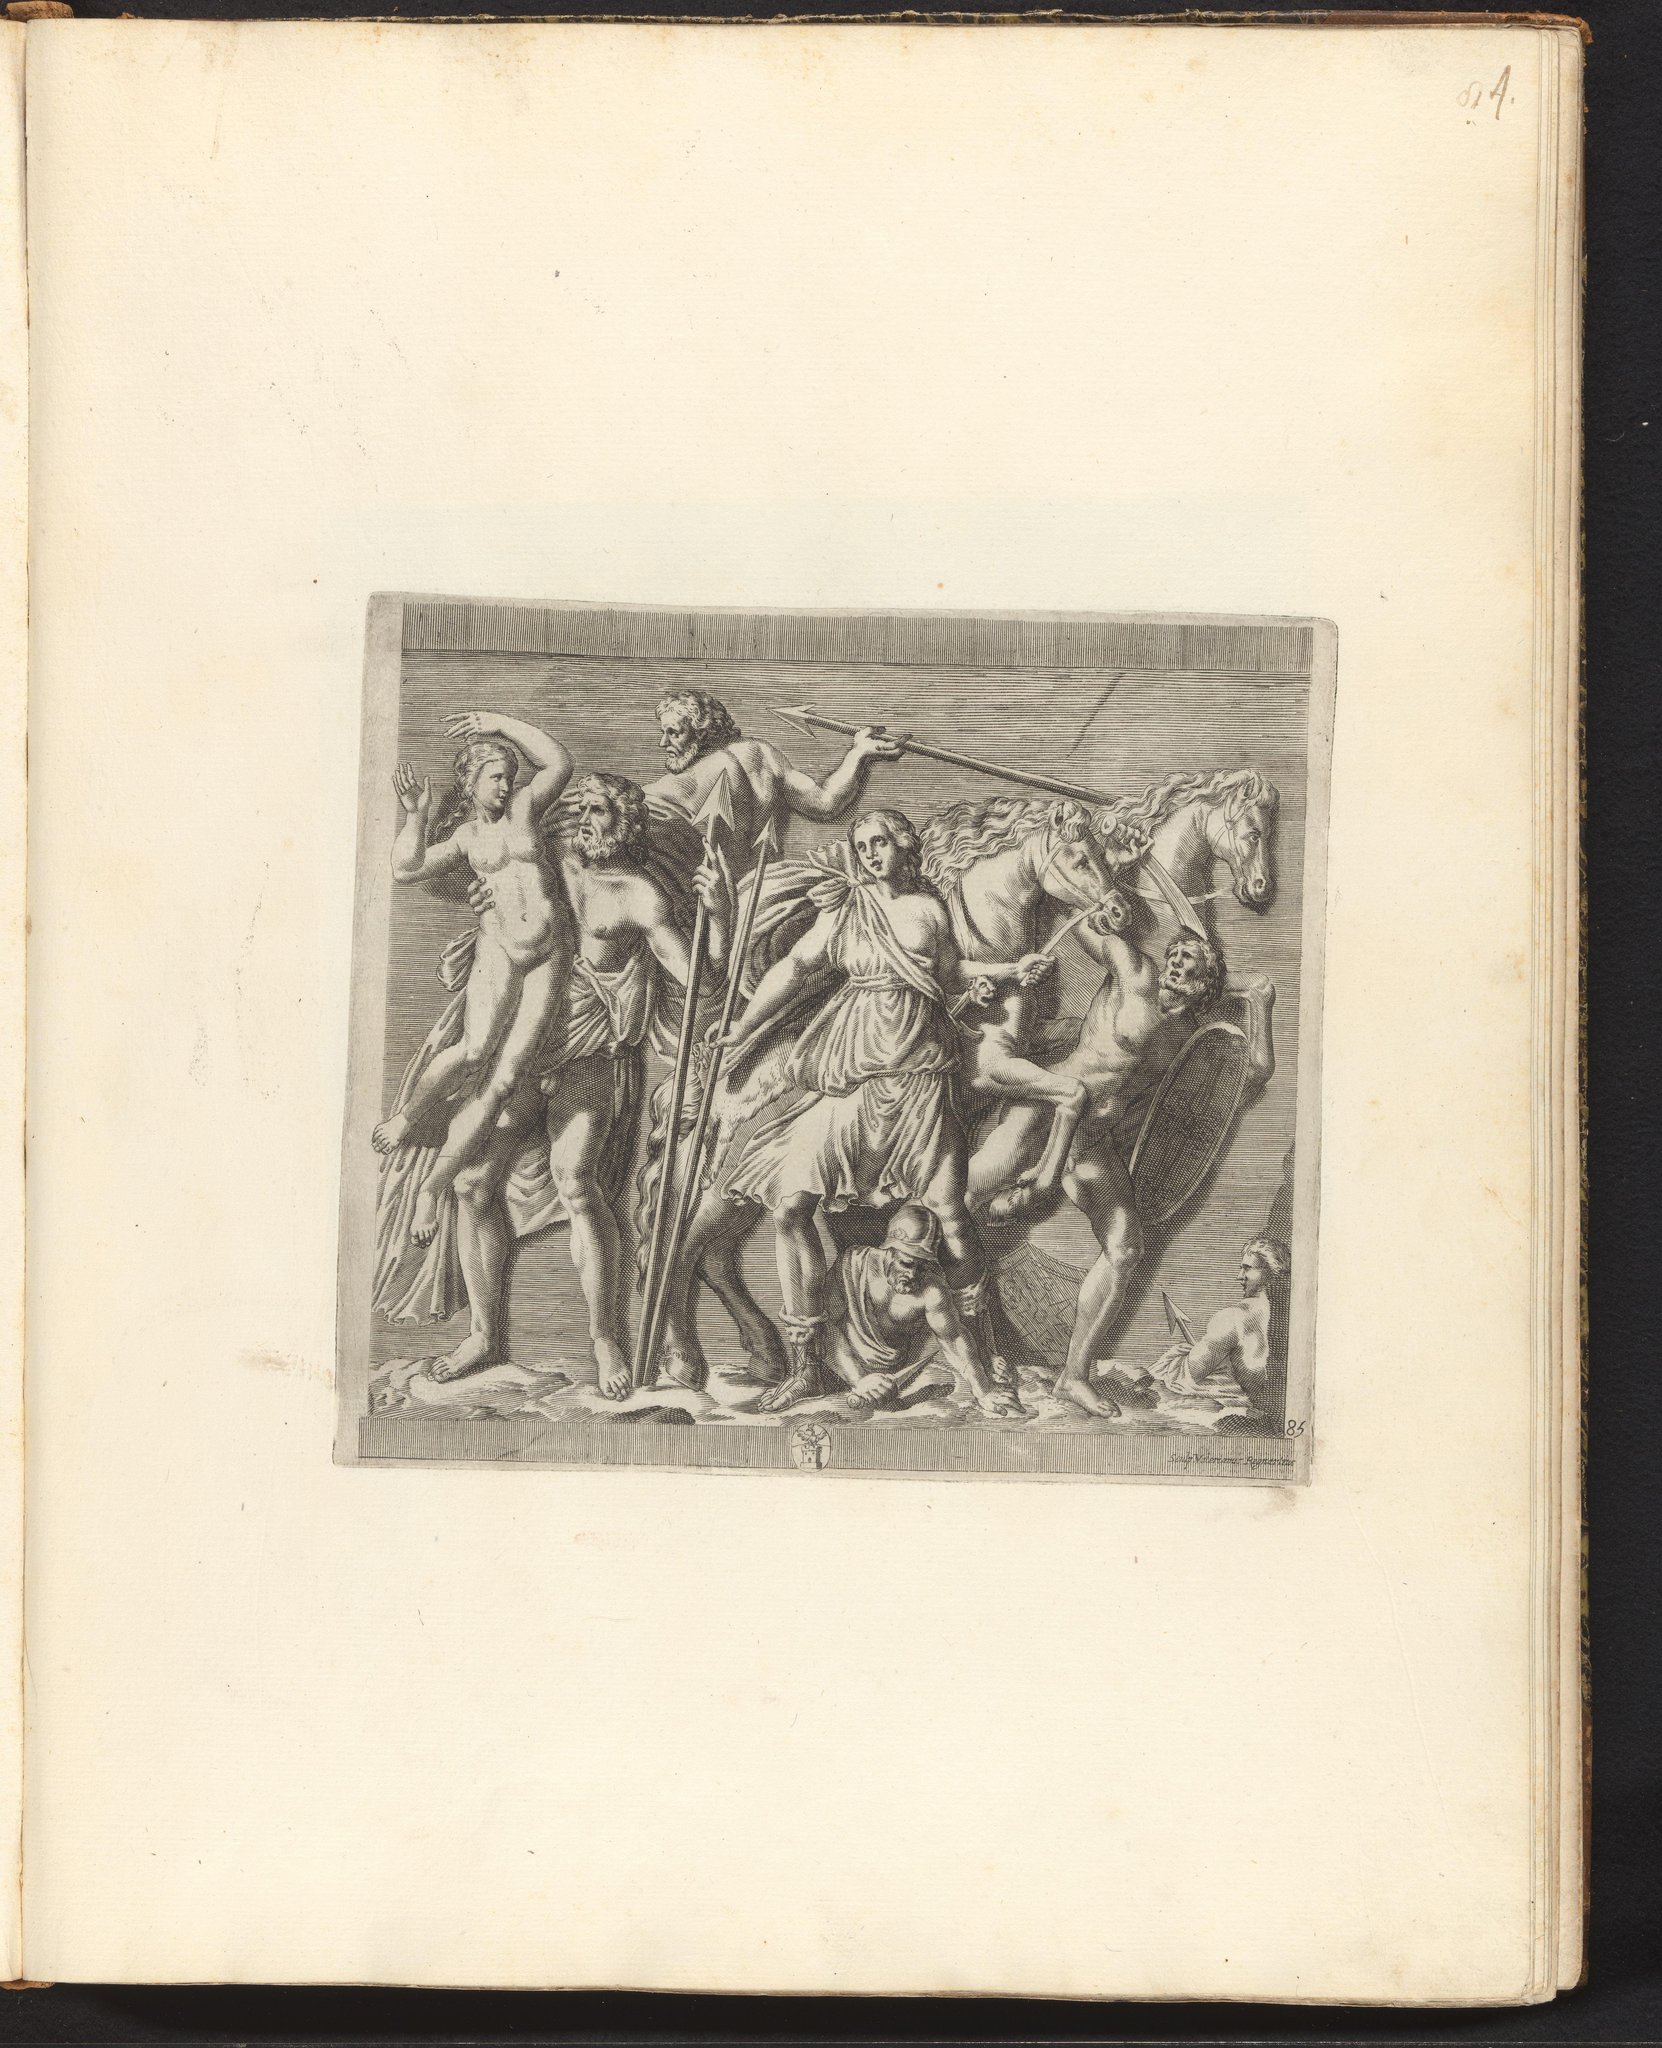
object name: print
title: Galleria Giustiniana del Marchese Vincenzo Giustiniani II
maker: valérien regnard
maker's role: print maker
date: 1636-1647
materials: paper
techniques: engraving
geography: rome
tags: rape of the sabine women: they are carried off by romulus and his men during a feast, piece of sculpture, reproduction of a piece of sculpture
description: Bas-reliëf met de Sabijnse maagdenroof. Links grijpt een soldaat een Sabijnse maagd vast. Rechts strijders met paarden. Midden onder het wapenschild van Vincenzo Giustiniani. Prent maakt deel uit van een album met een serie prenten naar de sculpturen in de verzameling in de Galleria Giustiniani te Rome.